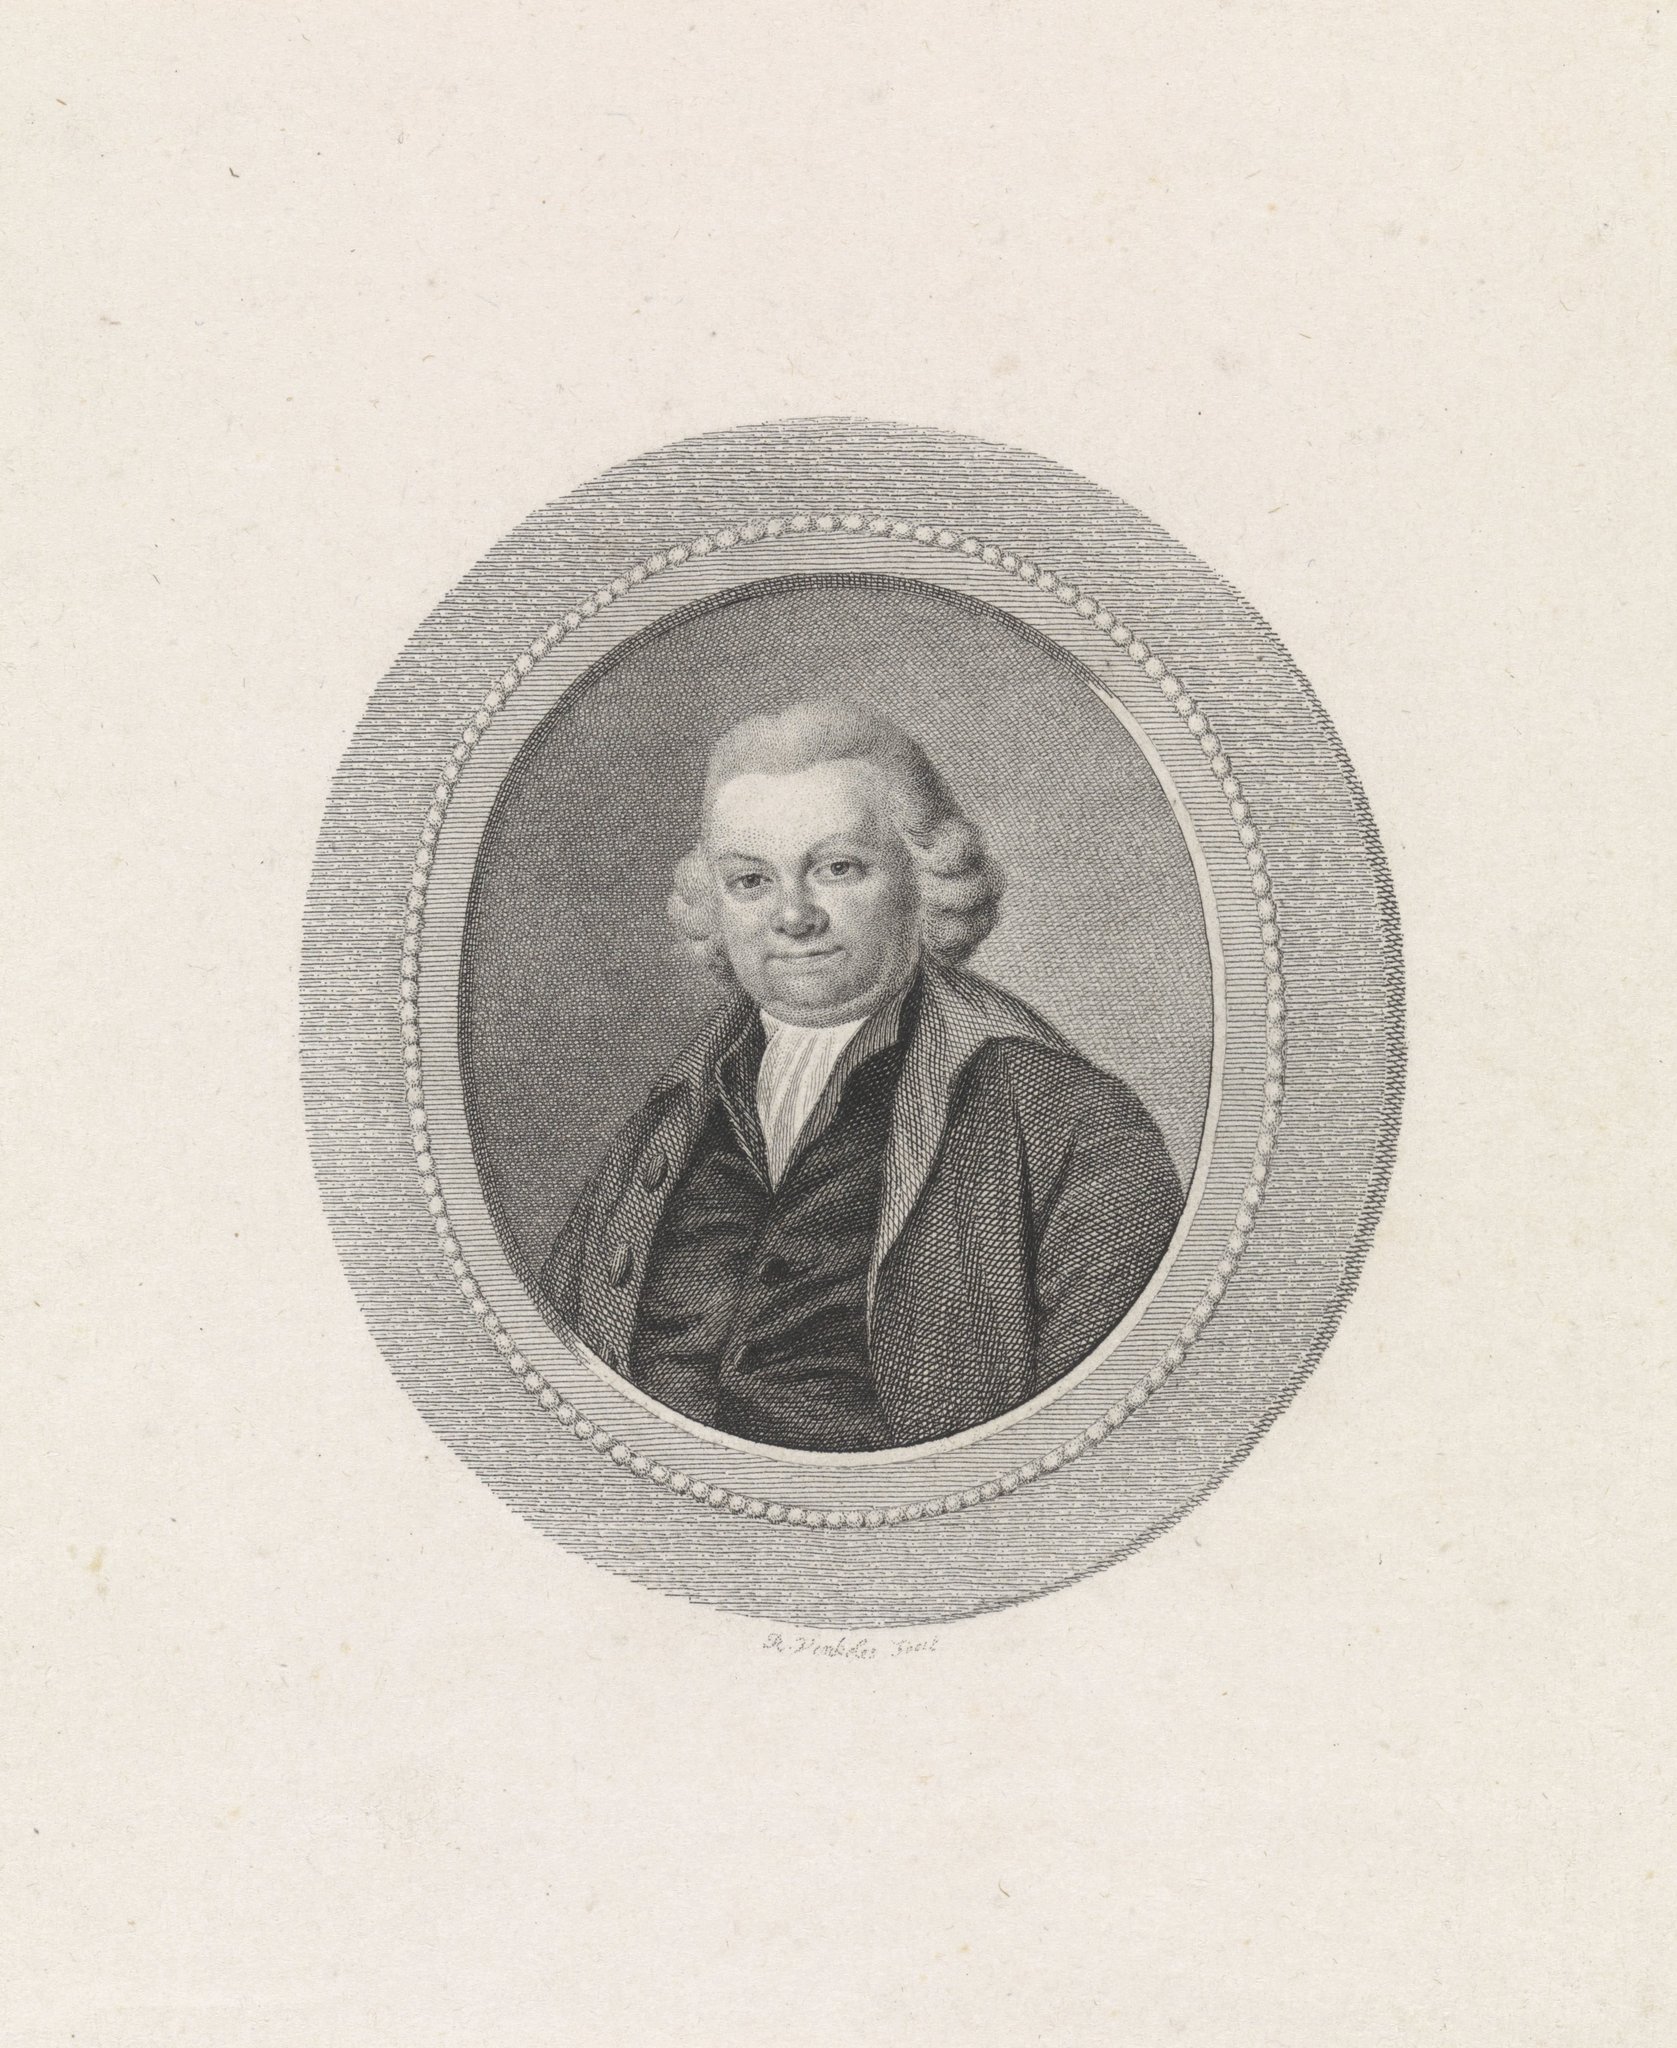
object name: print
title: Portret van Jeronimo de Bosch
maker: reinier vinkeles (i)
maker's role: draughtsman, print maker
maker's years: 1741-1816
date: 1808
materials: paper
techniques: etching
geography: amsterdam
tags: amsterdam, jeronimo de bosch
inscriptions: collector's mark: Lugt 2228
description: Latere staat prent gebruikt als titelpagina voor: Bosch, Jeronimo de. Poëmata. Utrecht: B. Wild en J. Altheer, 1808.